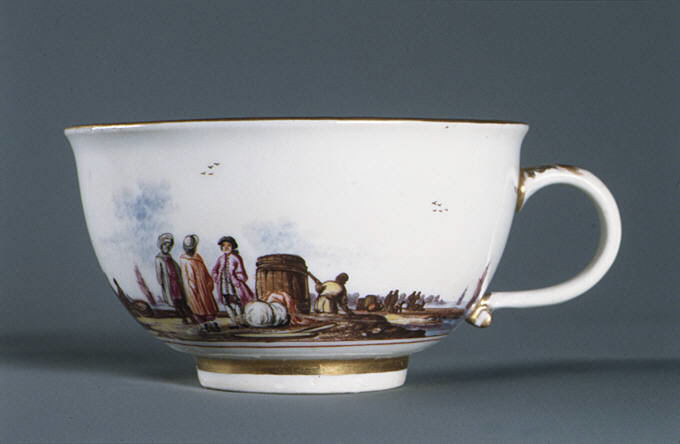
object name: cup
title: Cup (part of a service)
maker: meissen manufactory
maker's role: manufactory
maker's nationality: german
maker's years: 1710-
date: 1701-1800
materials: hard paste porcelain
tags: men